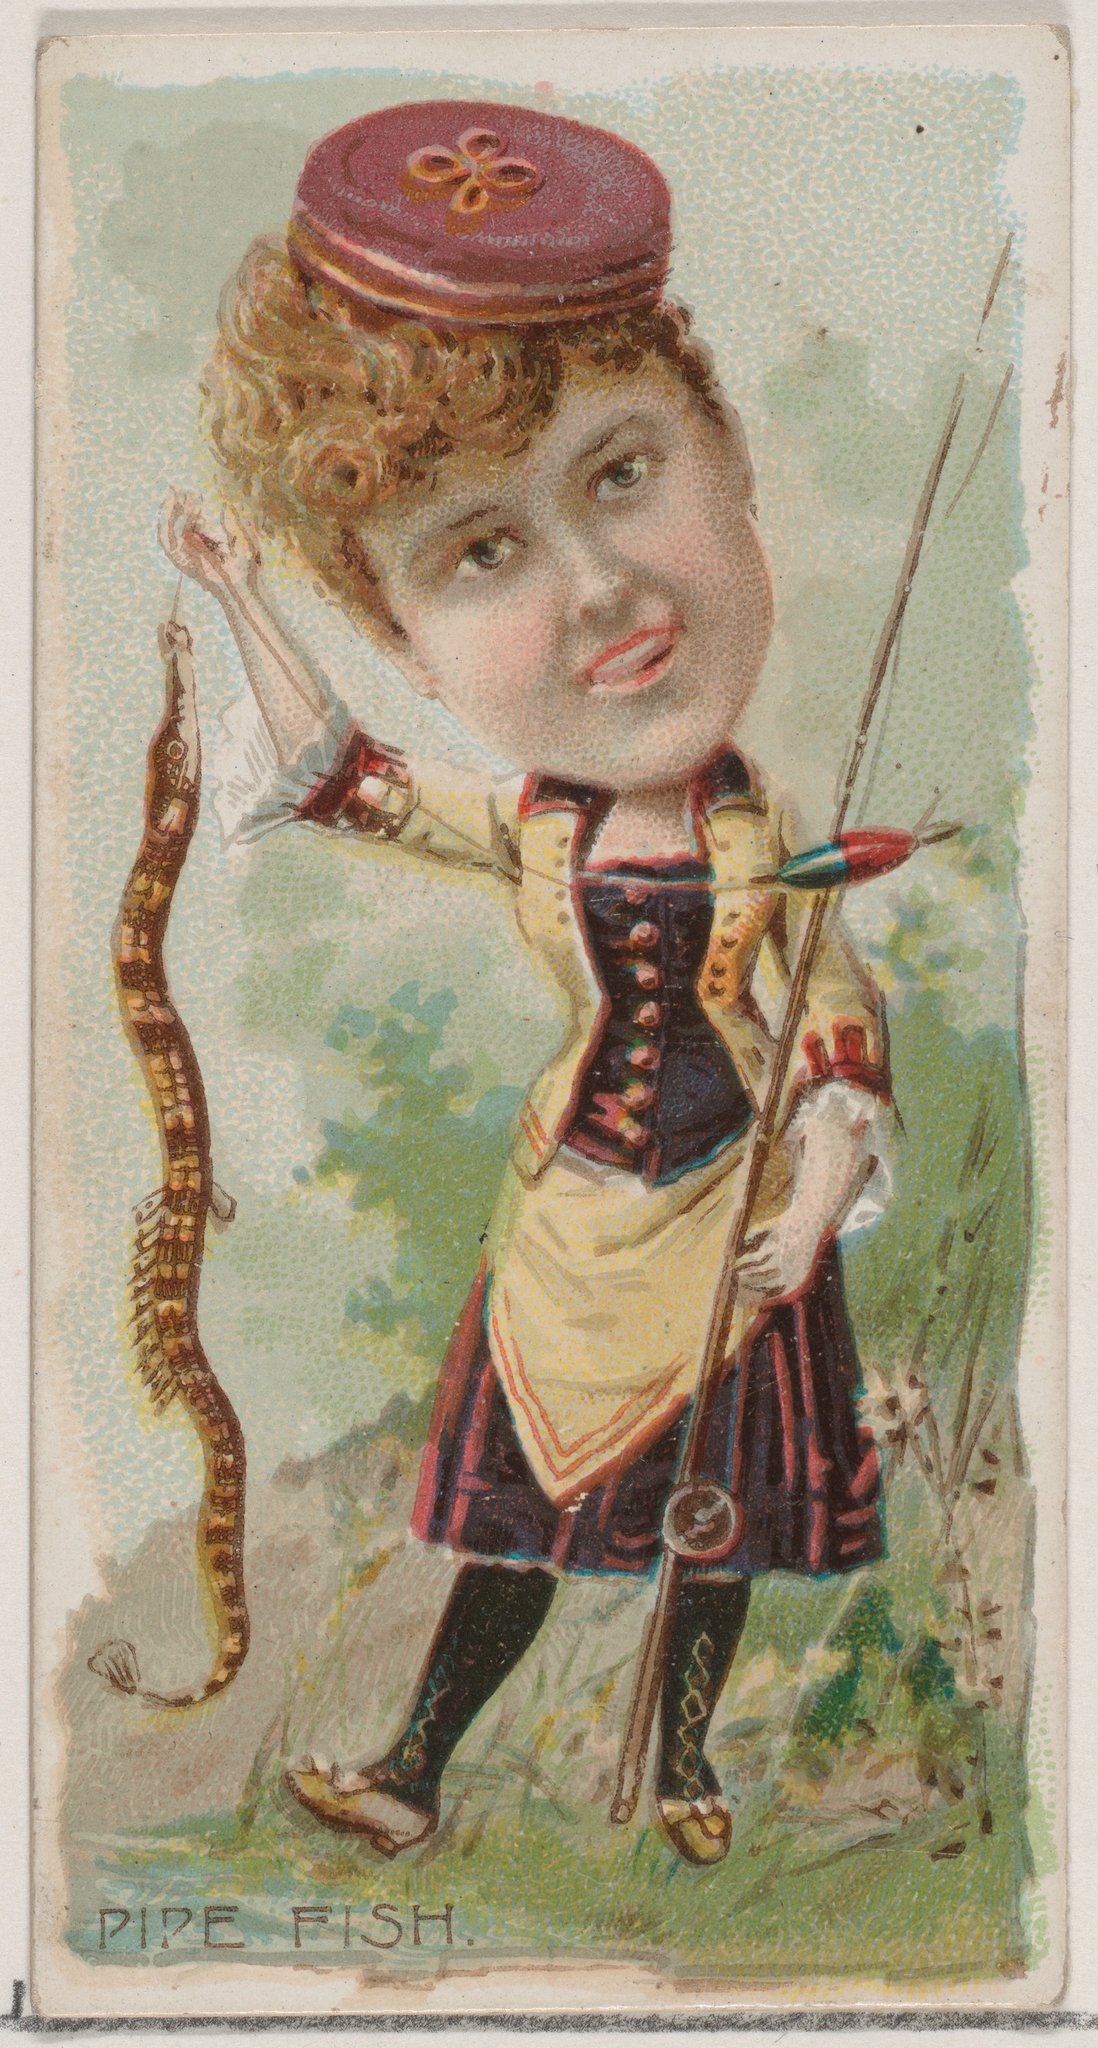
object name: print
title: Pipe Fish, from the series Fishers and Fish (N74) for Duke brand cigarettes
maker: knapp & company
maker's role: lithographer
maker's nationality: american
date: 1888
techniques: color lithograph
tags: women,fishing,fish